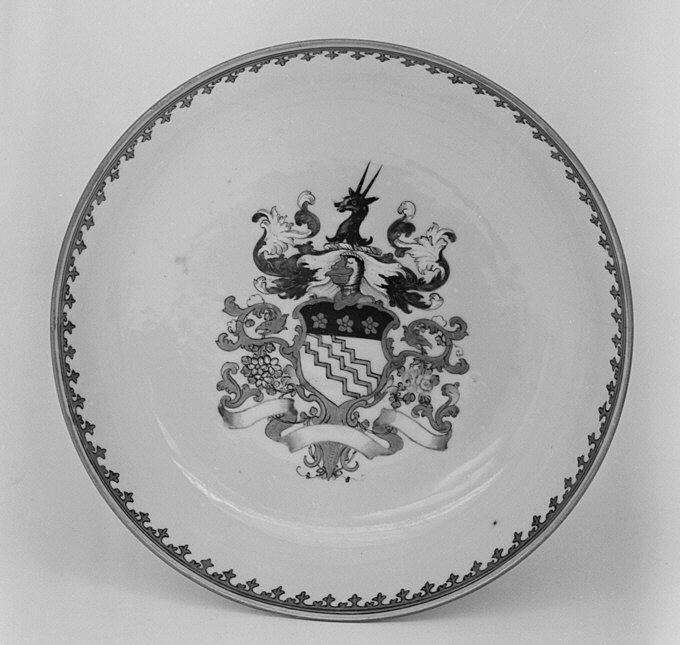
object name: saucer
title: Saucer (part of a service)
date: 1750-1760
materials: hard paste porcelain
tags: coat of arms